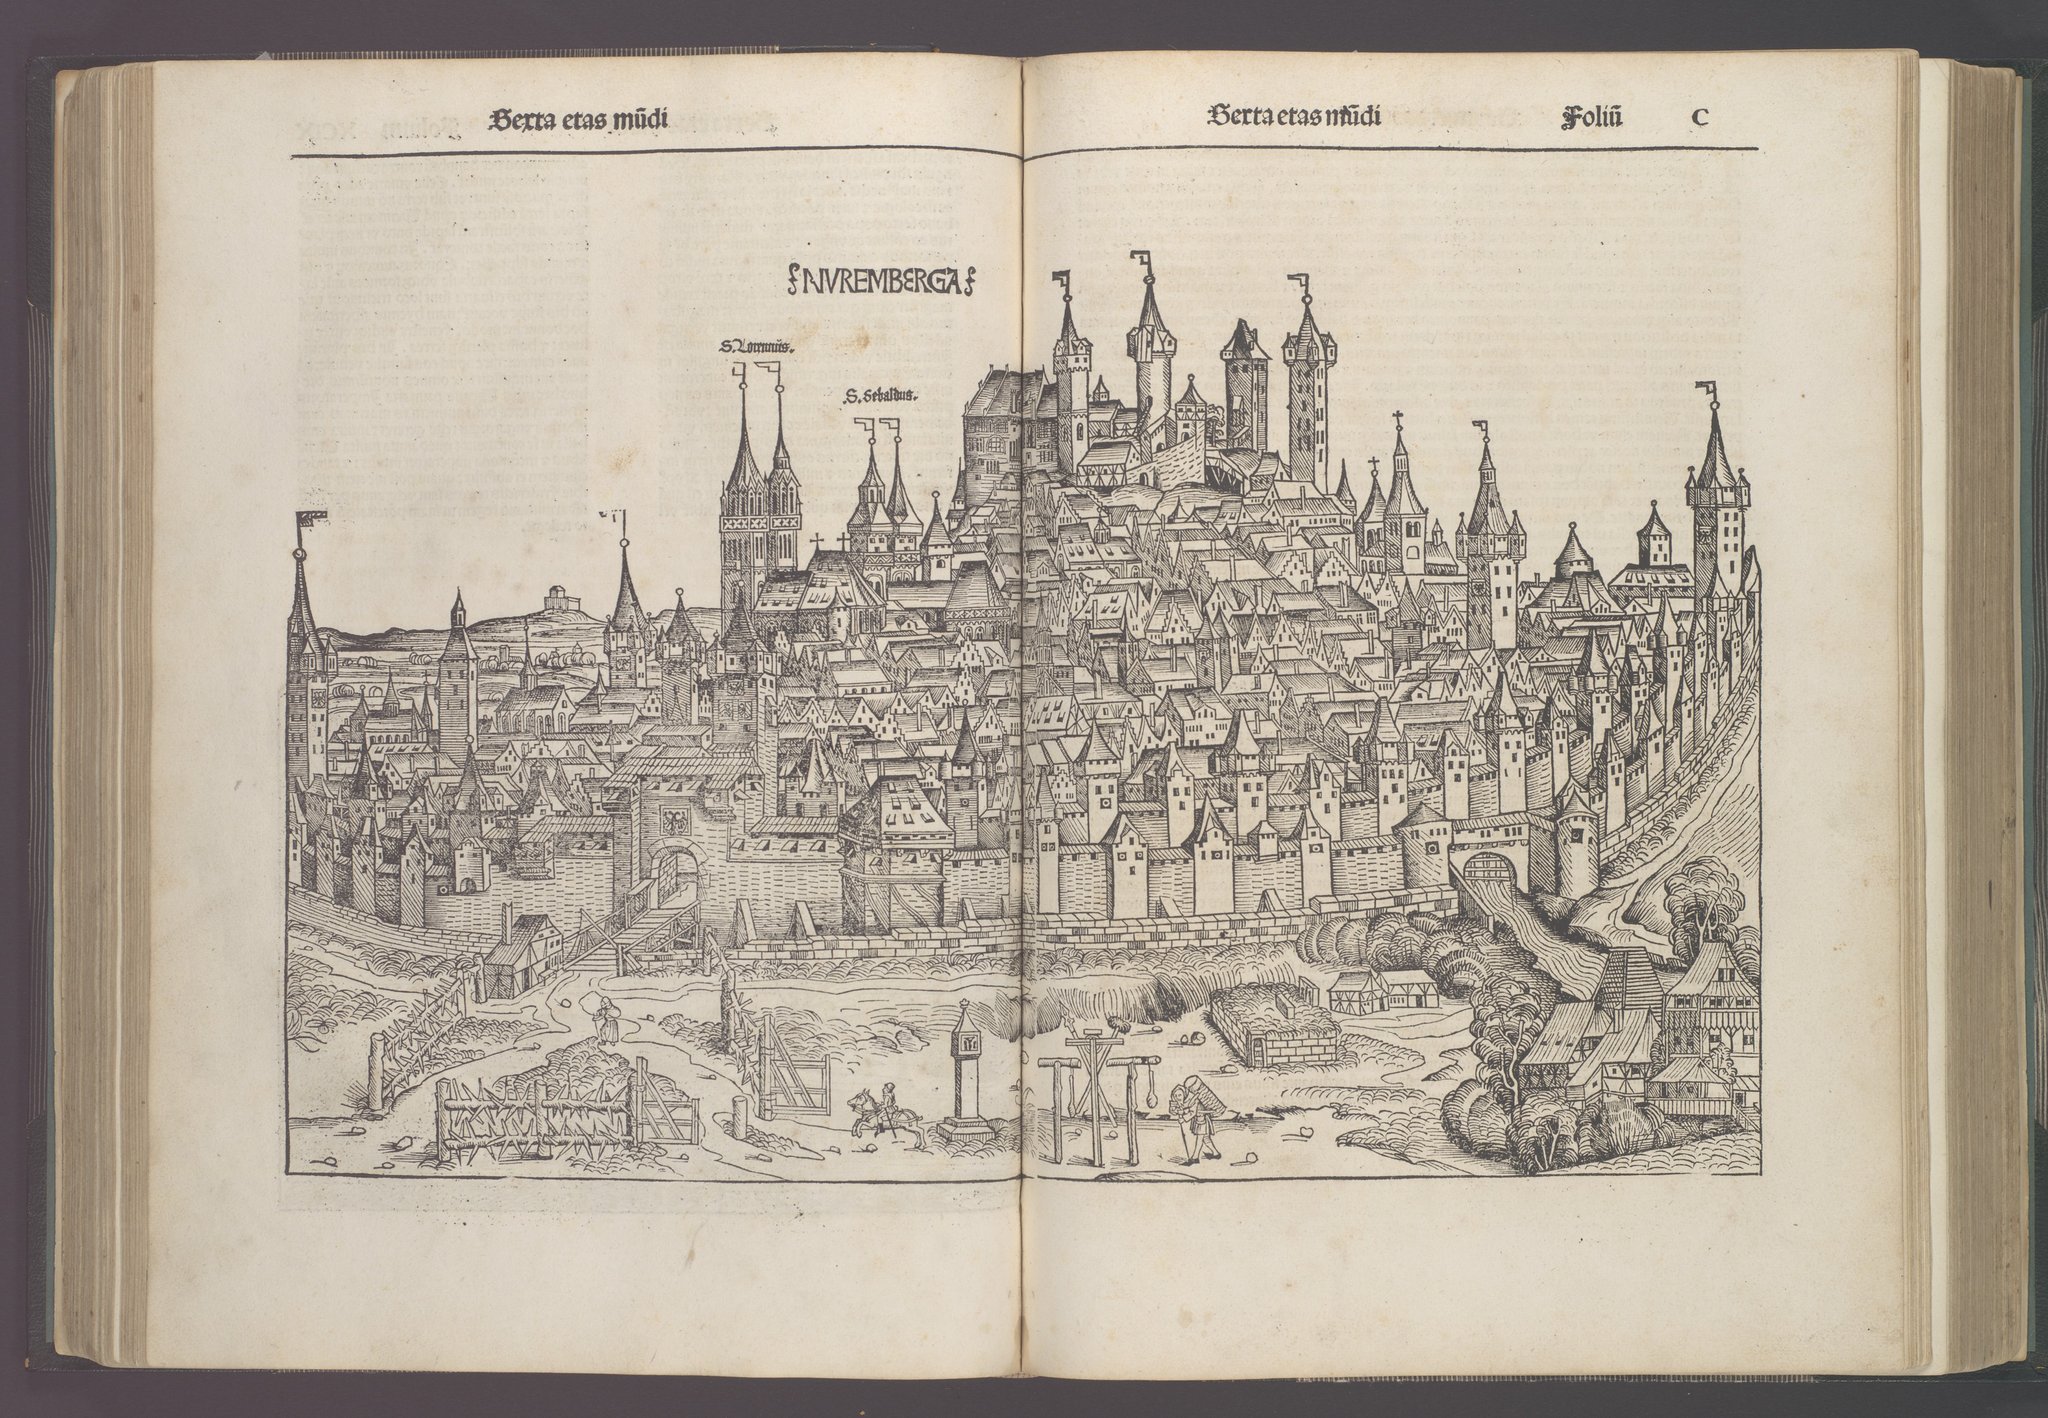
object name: book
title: (Liber chronicarum) Registrum huius operis libri cronicarum cum figuris et ymagibus ab inicio mundi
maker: hartmann schedel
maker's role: author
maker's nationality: german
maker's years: 1440-1514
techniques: letterpress, woodcut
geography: germany